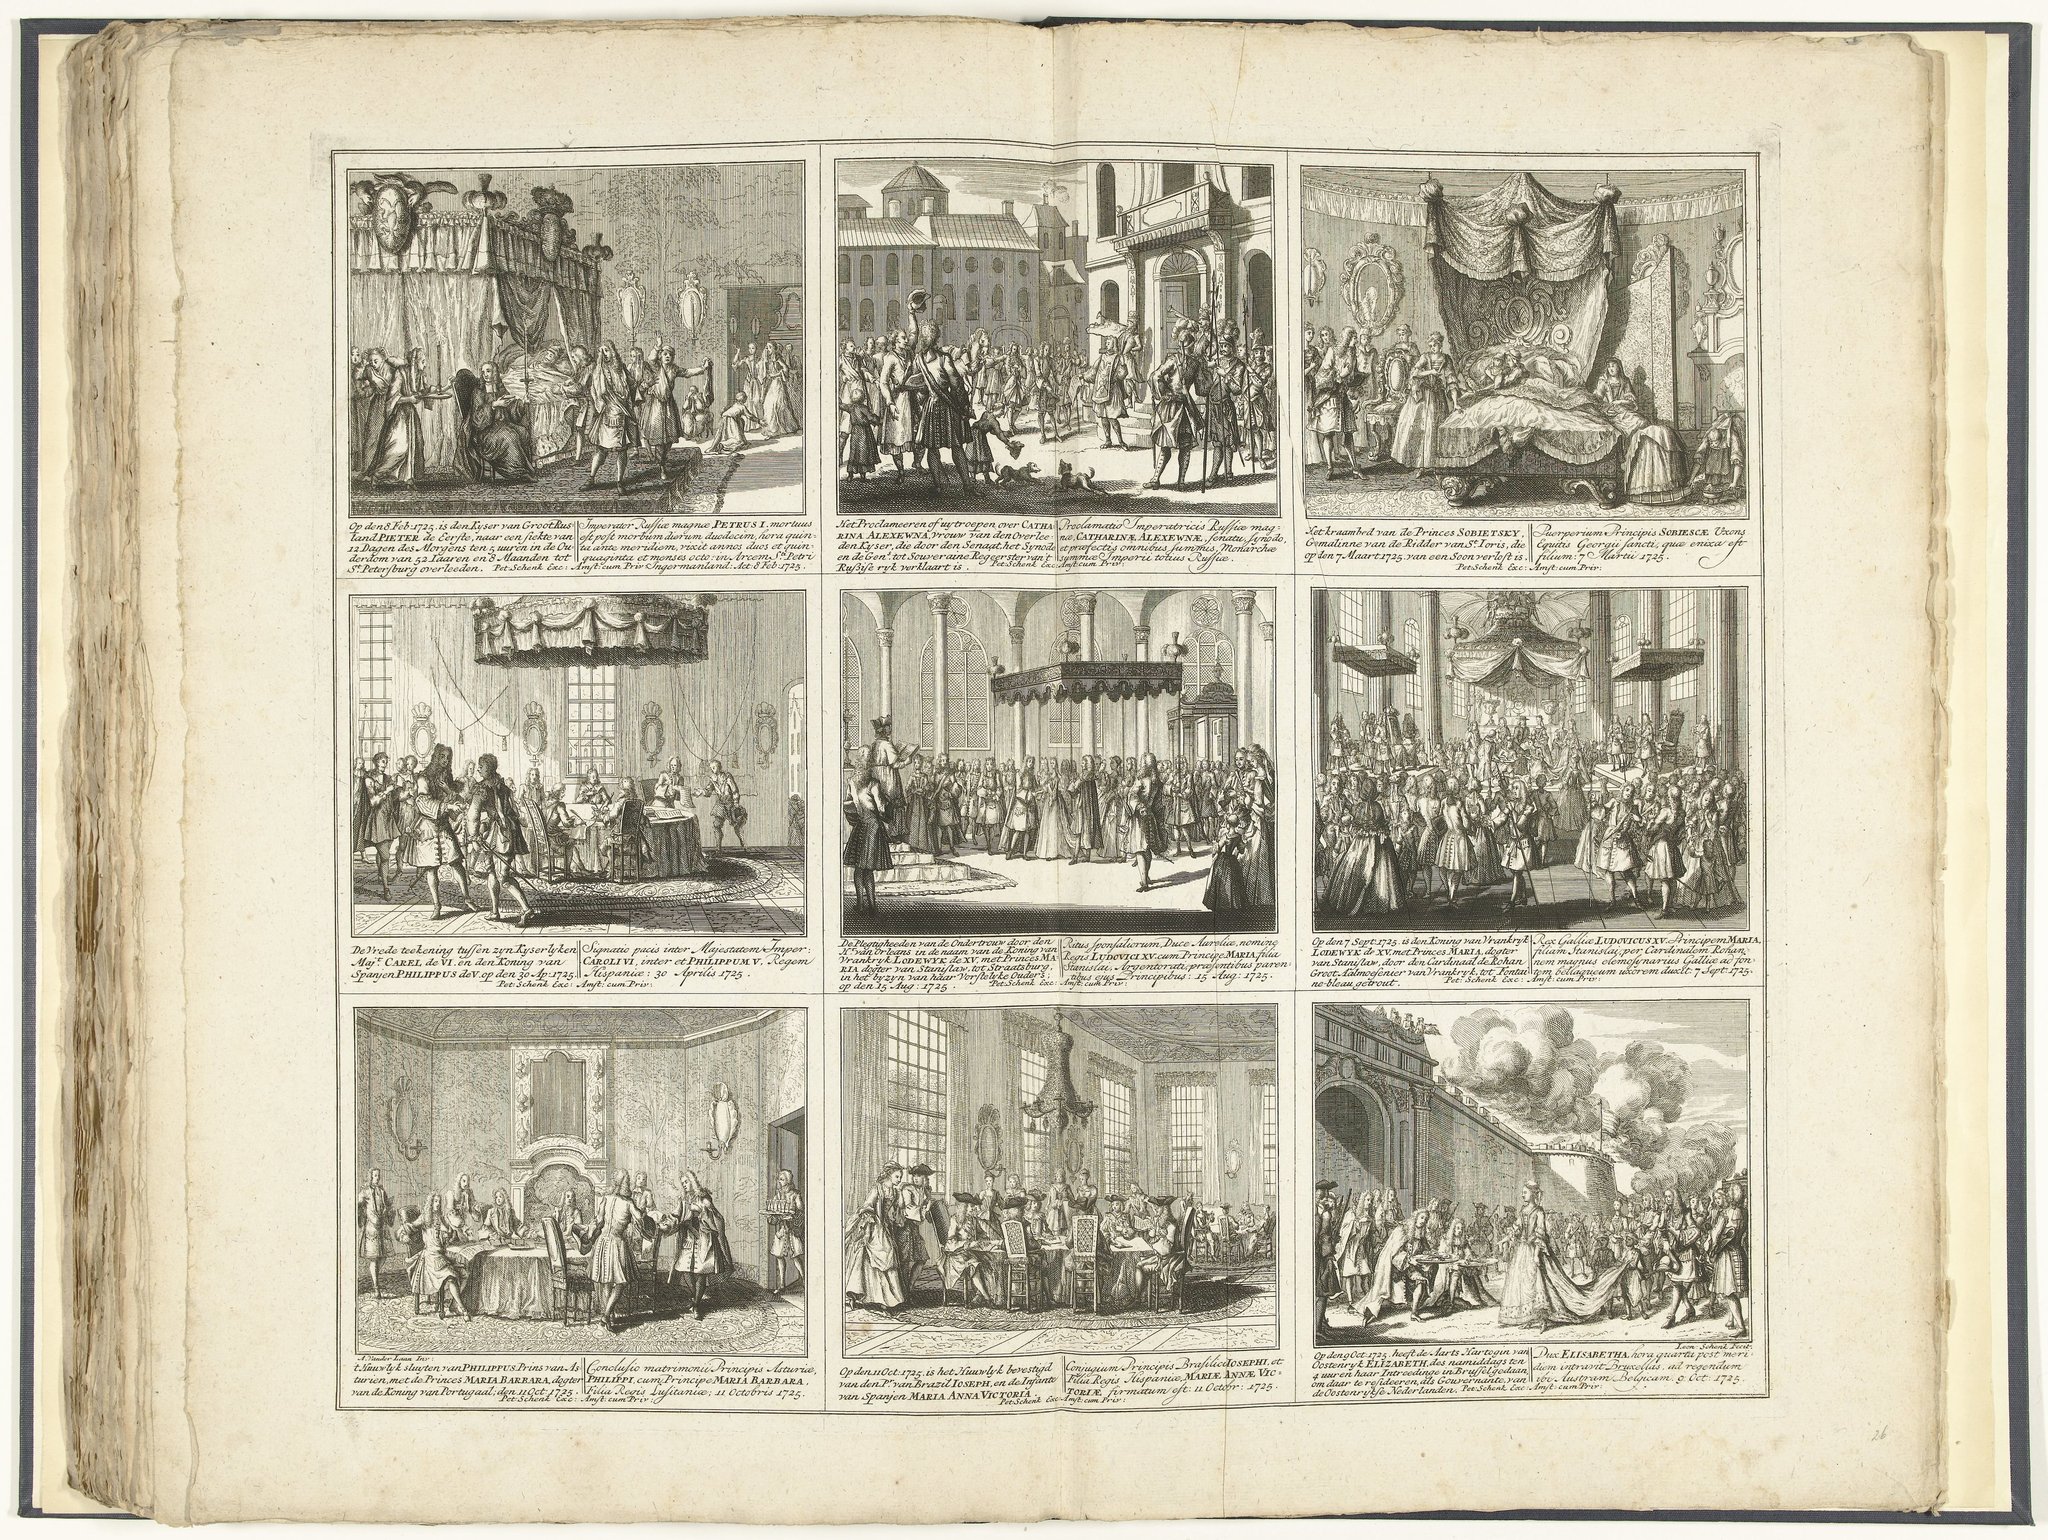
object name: print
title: Schouwtoneel van den Oorlog Beginnende met Koning Karel den tweeden Bestaande in Veldslagen, en Belegeringen, Zoo te Water als te Lande, met de voornaamste Vestingen (...)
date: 1725-1727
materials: paper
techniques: engraving, etching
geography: amsterdam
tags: peter i de grote (tsaar van rusland), louis xv of france, triumphal entry and public reception, pageant, 'entrée solennelle', 'joyeuse entrée', deathbed, (civil) marriage ceremonies, confinement, birth, brussels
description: Blad met negen voorstellingen van gebeurtenissen uit het jaar 1725. Opschriften in de voorstelling in het Nederlands en Latijn. Plaat 31 in het prentwerk met de gebundelde reeks van 33 platen met voorstellingen (het merendeel verdeeld in 9 kleinere scènes) van gebeurtenissen uit de jaren 1700-1727 van de Spaanse Successieoorlog en de jaren daarna, kaarten en plattegronden.